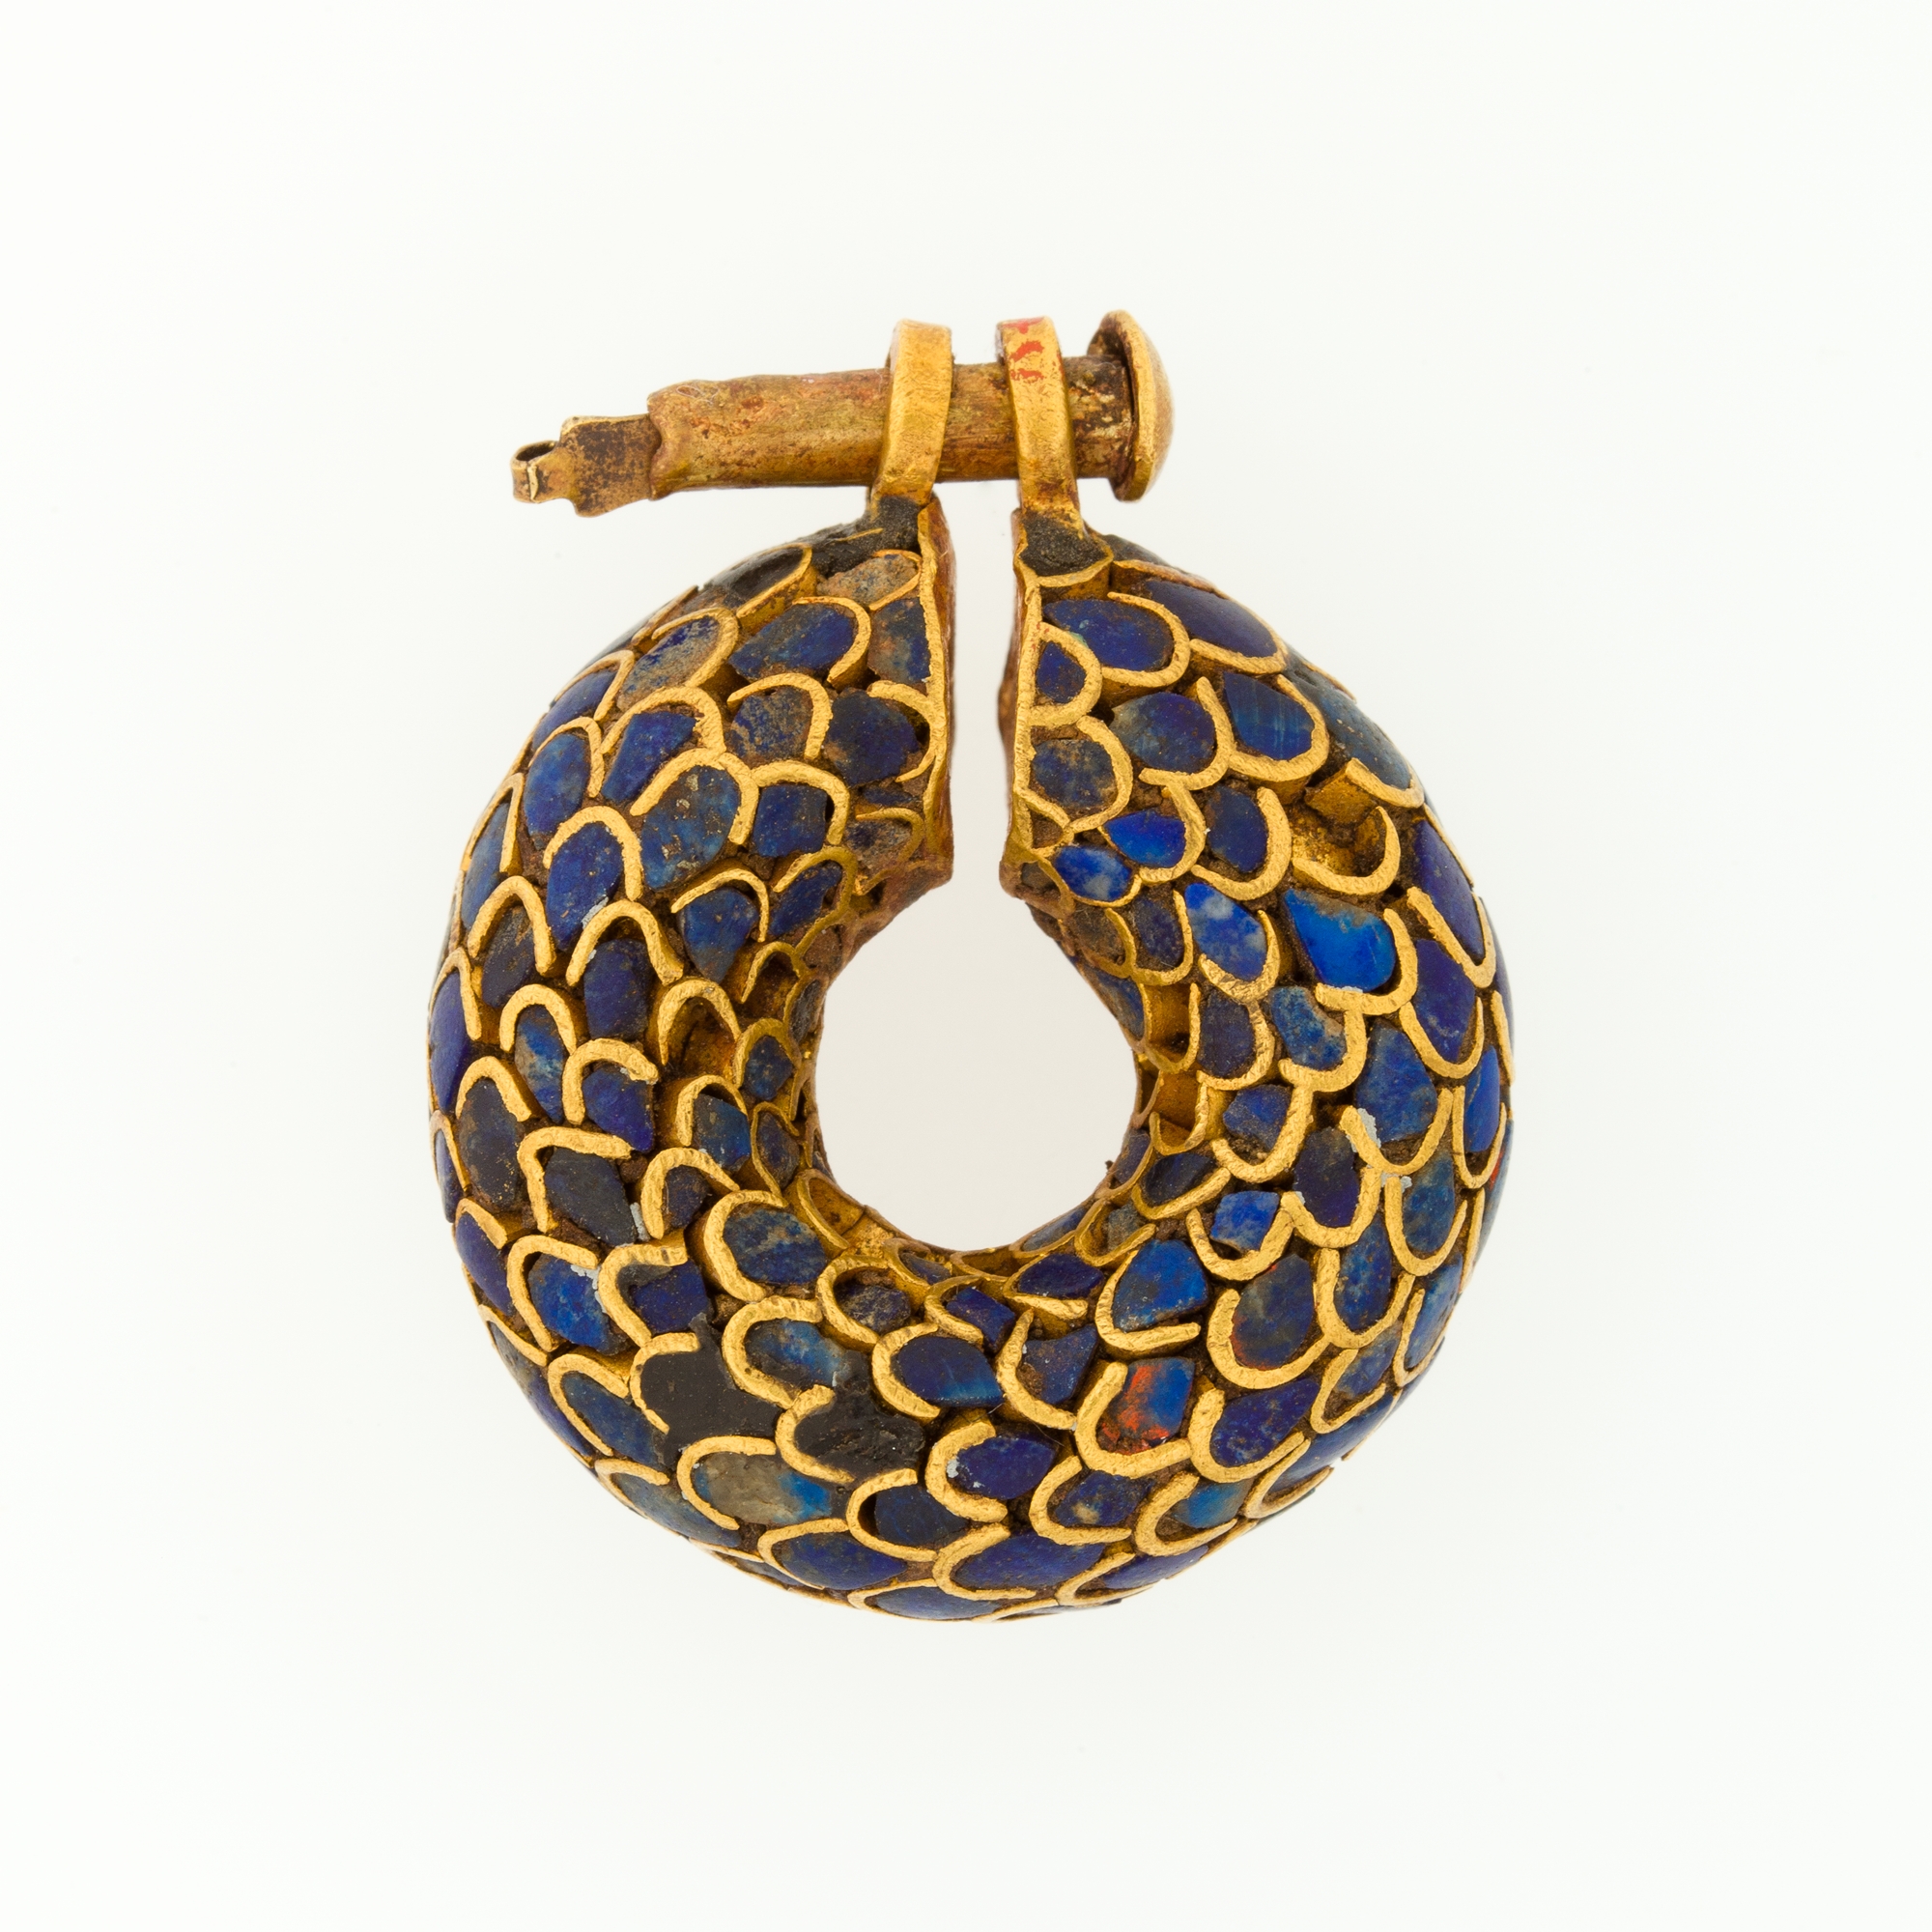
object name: earring, feather pattern, penannular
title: Earring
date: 1295-1186 BCE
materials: gold, lapis lazuli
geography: egypt